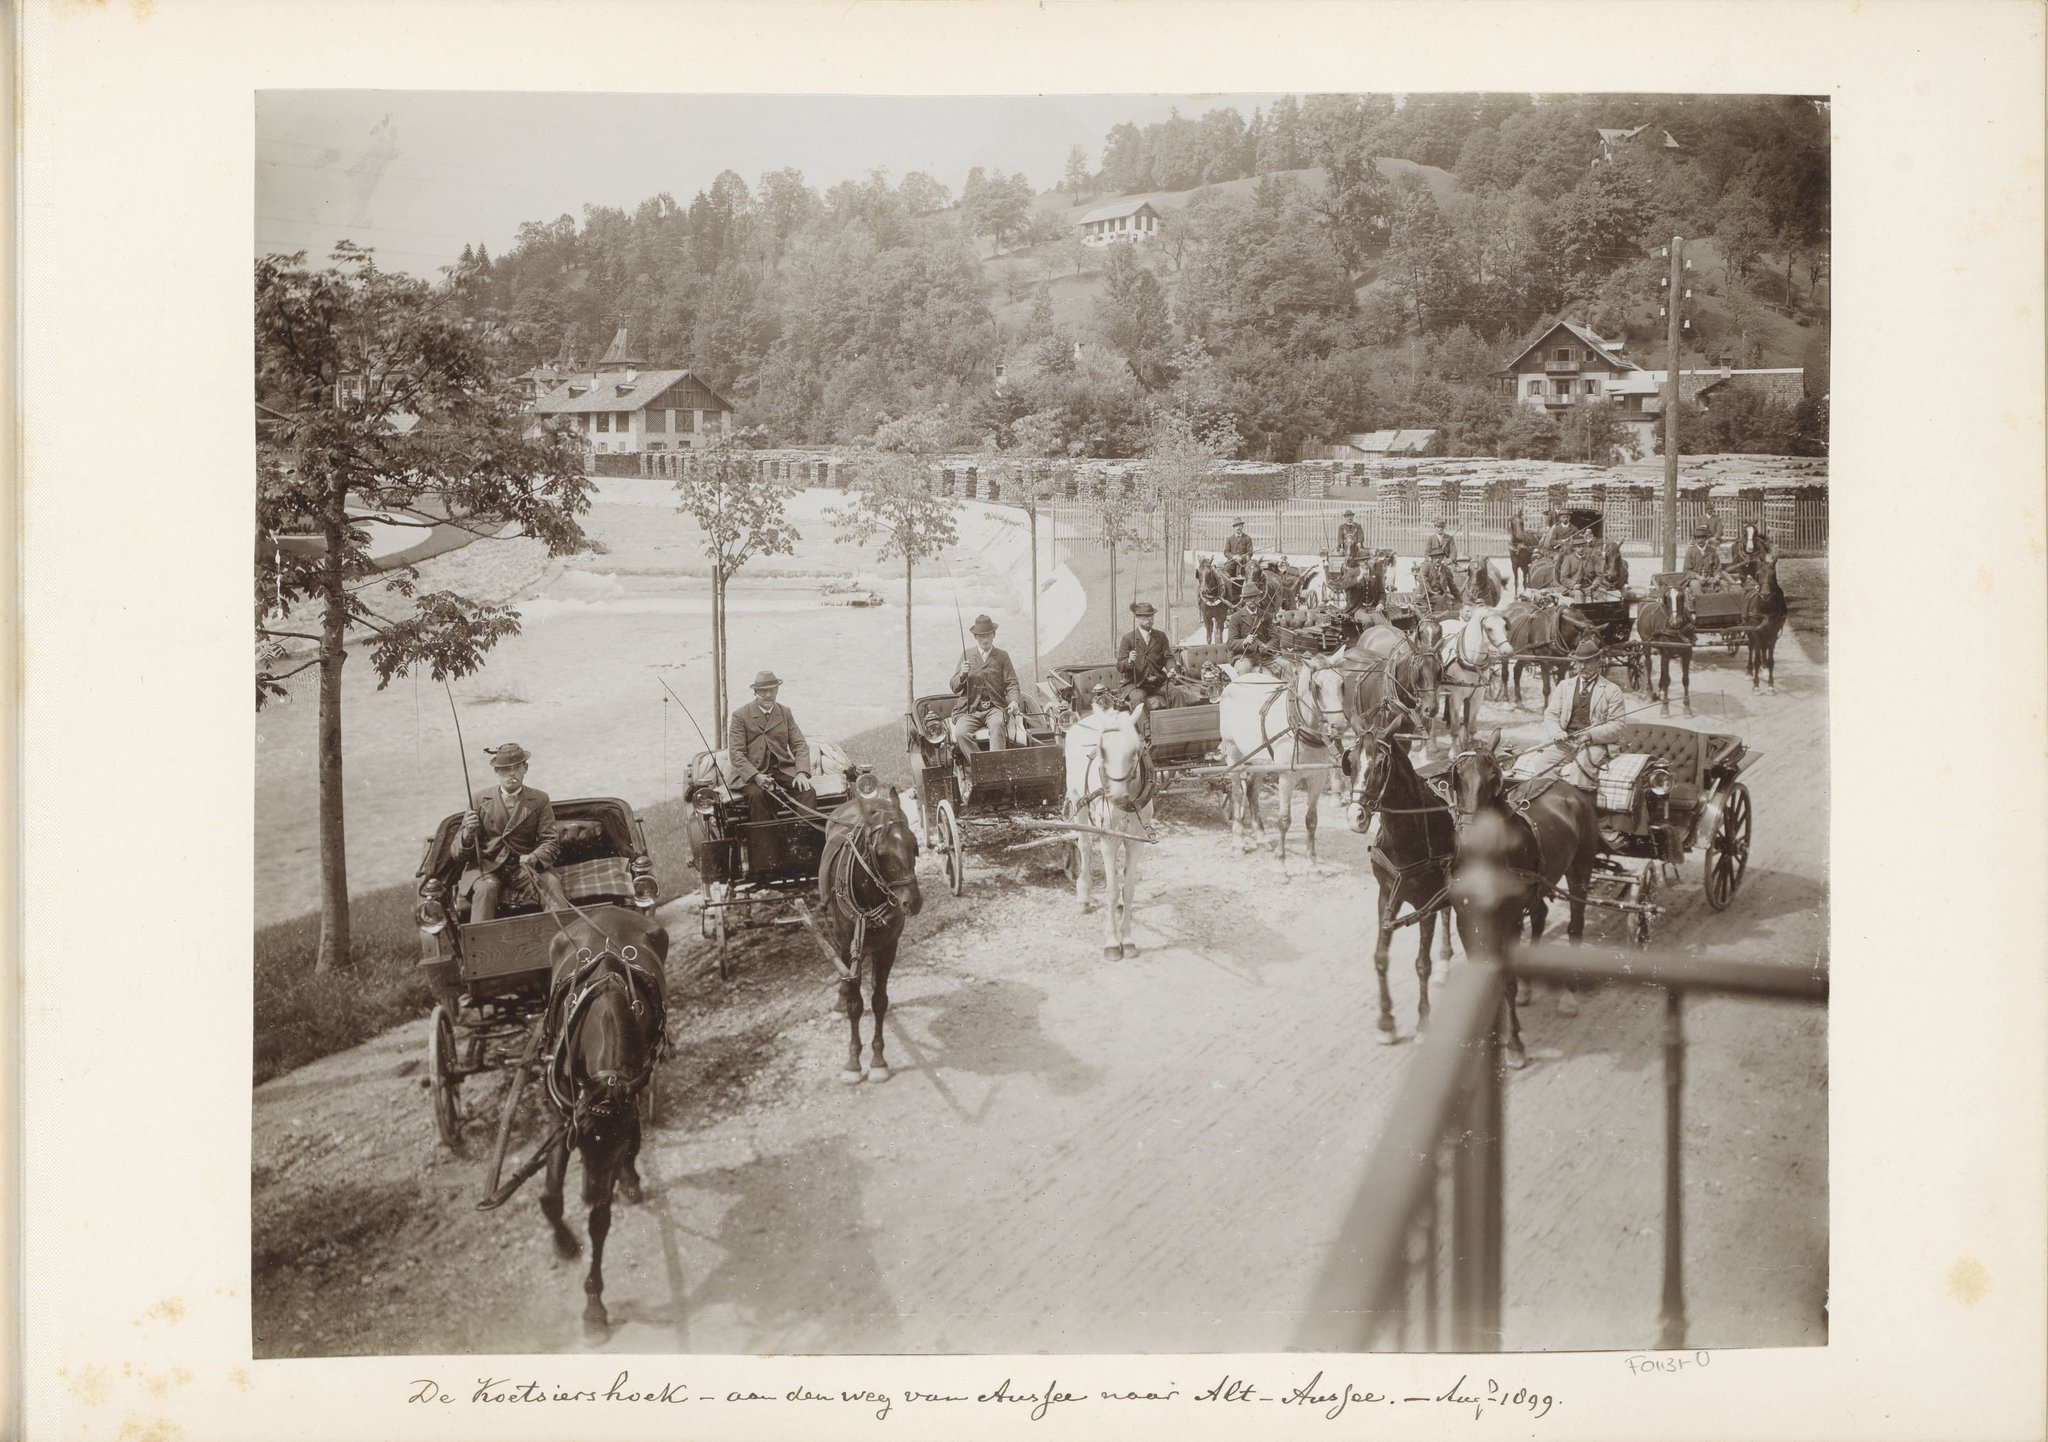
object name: photograph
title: Wachtende koetsiers met paard en wagen langs de weg van Aussee naar Altaussee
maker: Anonymous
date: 1880-1899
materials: paper, photographic support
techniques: collodion silver print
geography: salzkammergut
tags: four-wheeled, animal-drawn vehicle, e.g.: cab, carriage, coach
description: Onderdeel van Reisalbum met bezienswaardigheden in Duitsland, Oostenrijk, Zwitserland, Luxemburg en België.